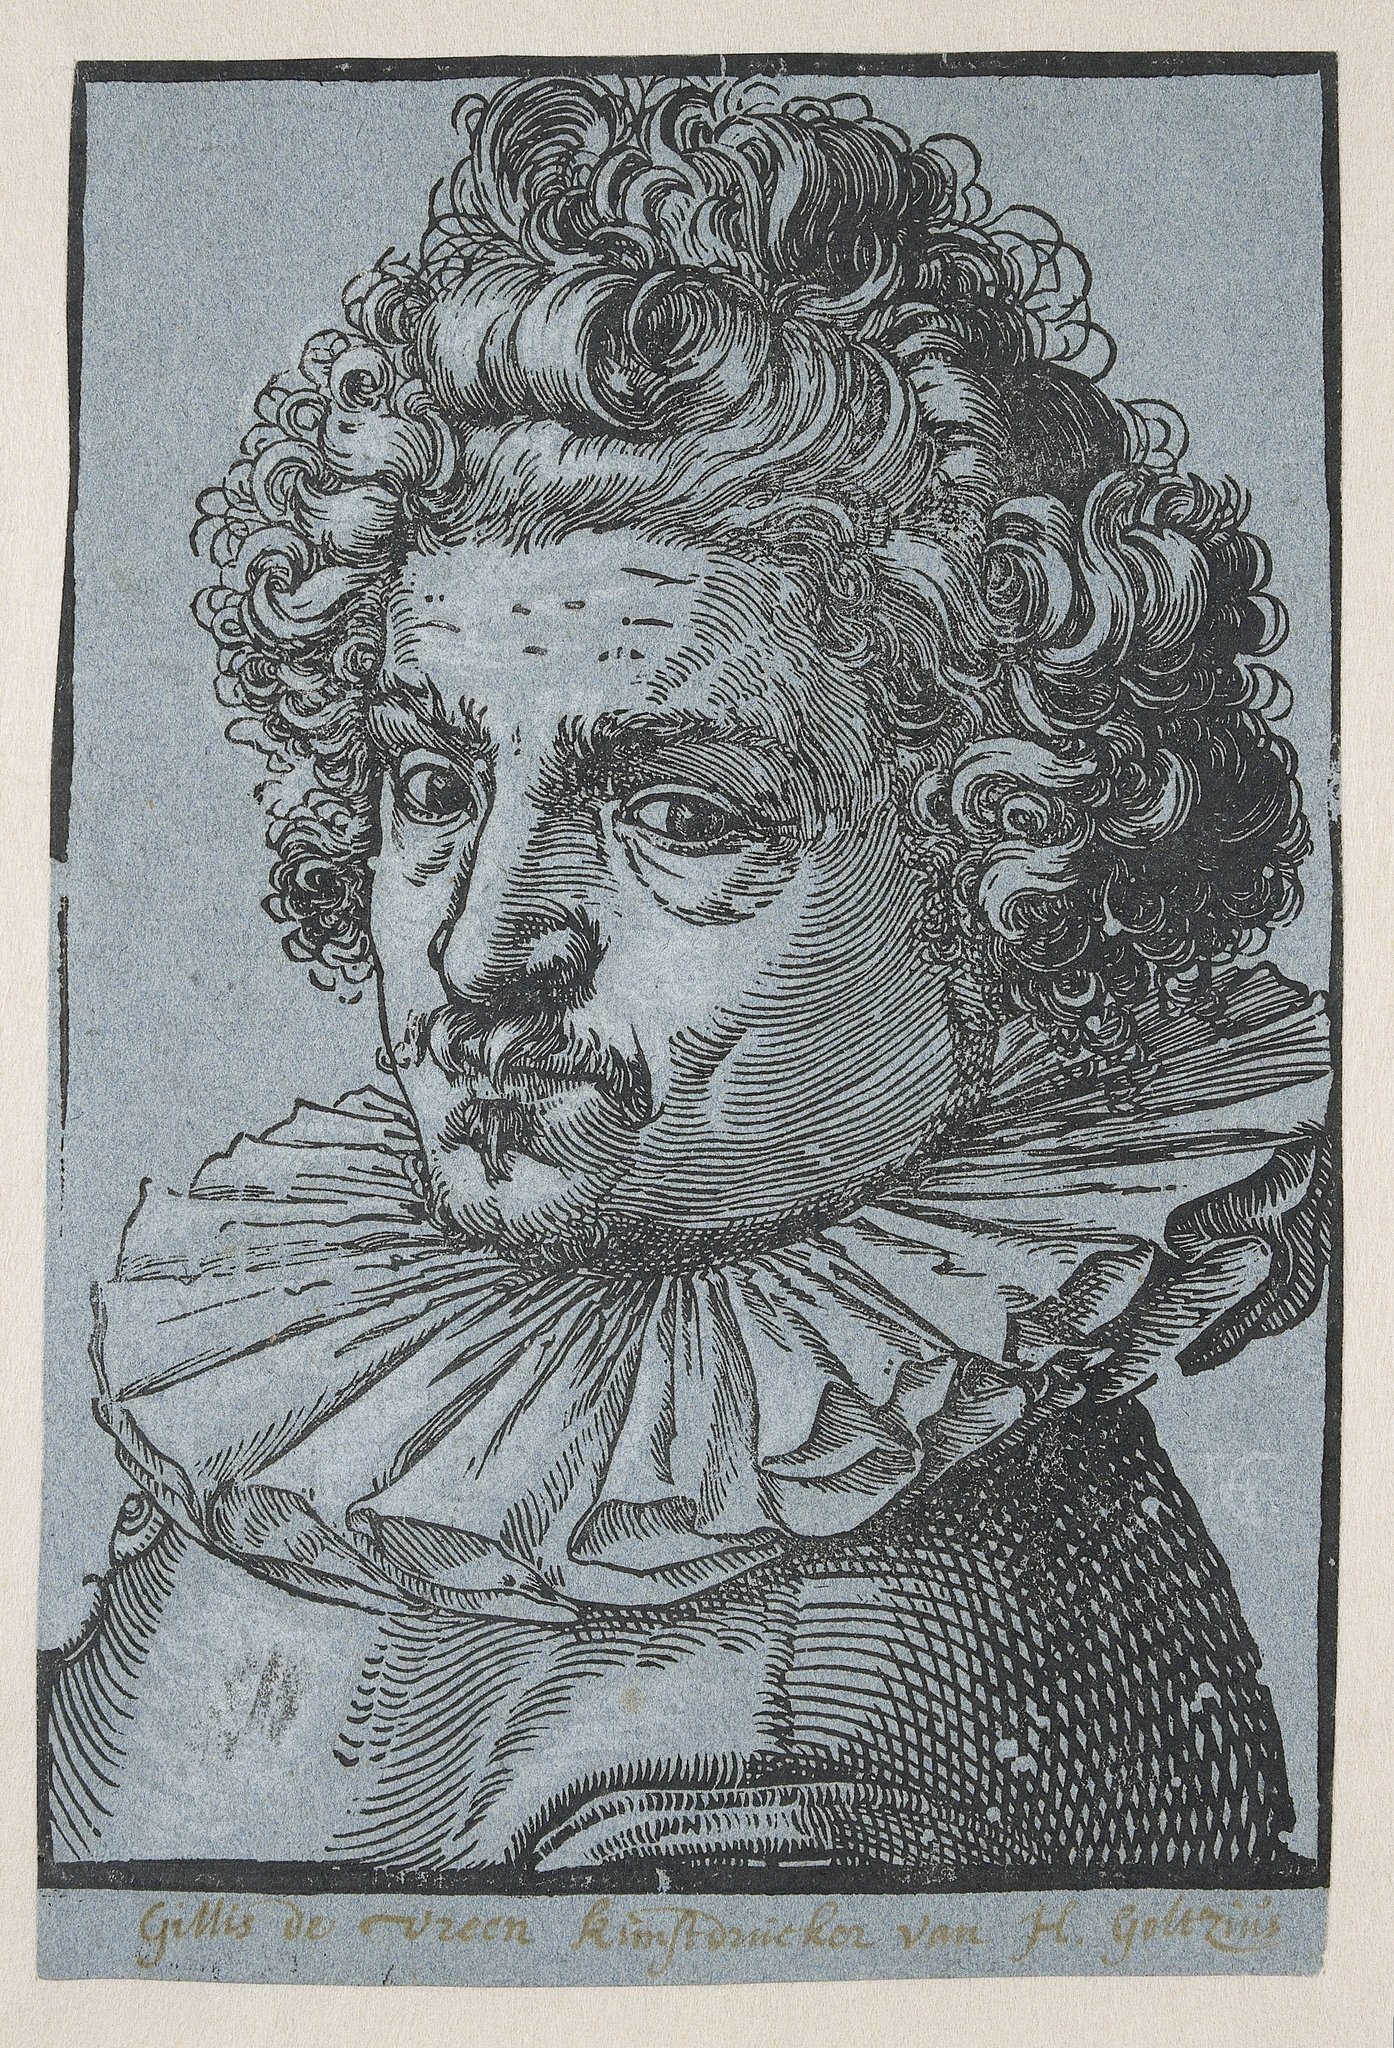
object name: print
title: Portret van Gillis van Breen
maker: hendrick goltzius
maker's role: draughtsman, painter, print maker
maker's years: 1558-1617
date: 1586-1590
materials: paint, paper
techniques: woodcut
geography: haarlem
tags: print maker, gillis van breen, historical persons, portrait, self-portrait of artist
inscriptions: caption: ‘Gillis de Vreen kunstdrucker van H. Goltzius’, collector's mark: Lugt 2228a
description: Portret van een man (Gillis van Breen, een vriend, misschien ook assistent van Goltzius) met krullend haar en een geplooide kraag, op de linkerzijde gezien, de blik gericht op de beschouwer.